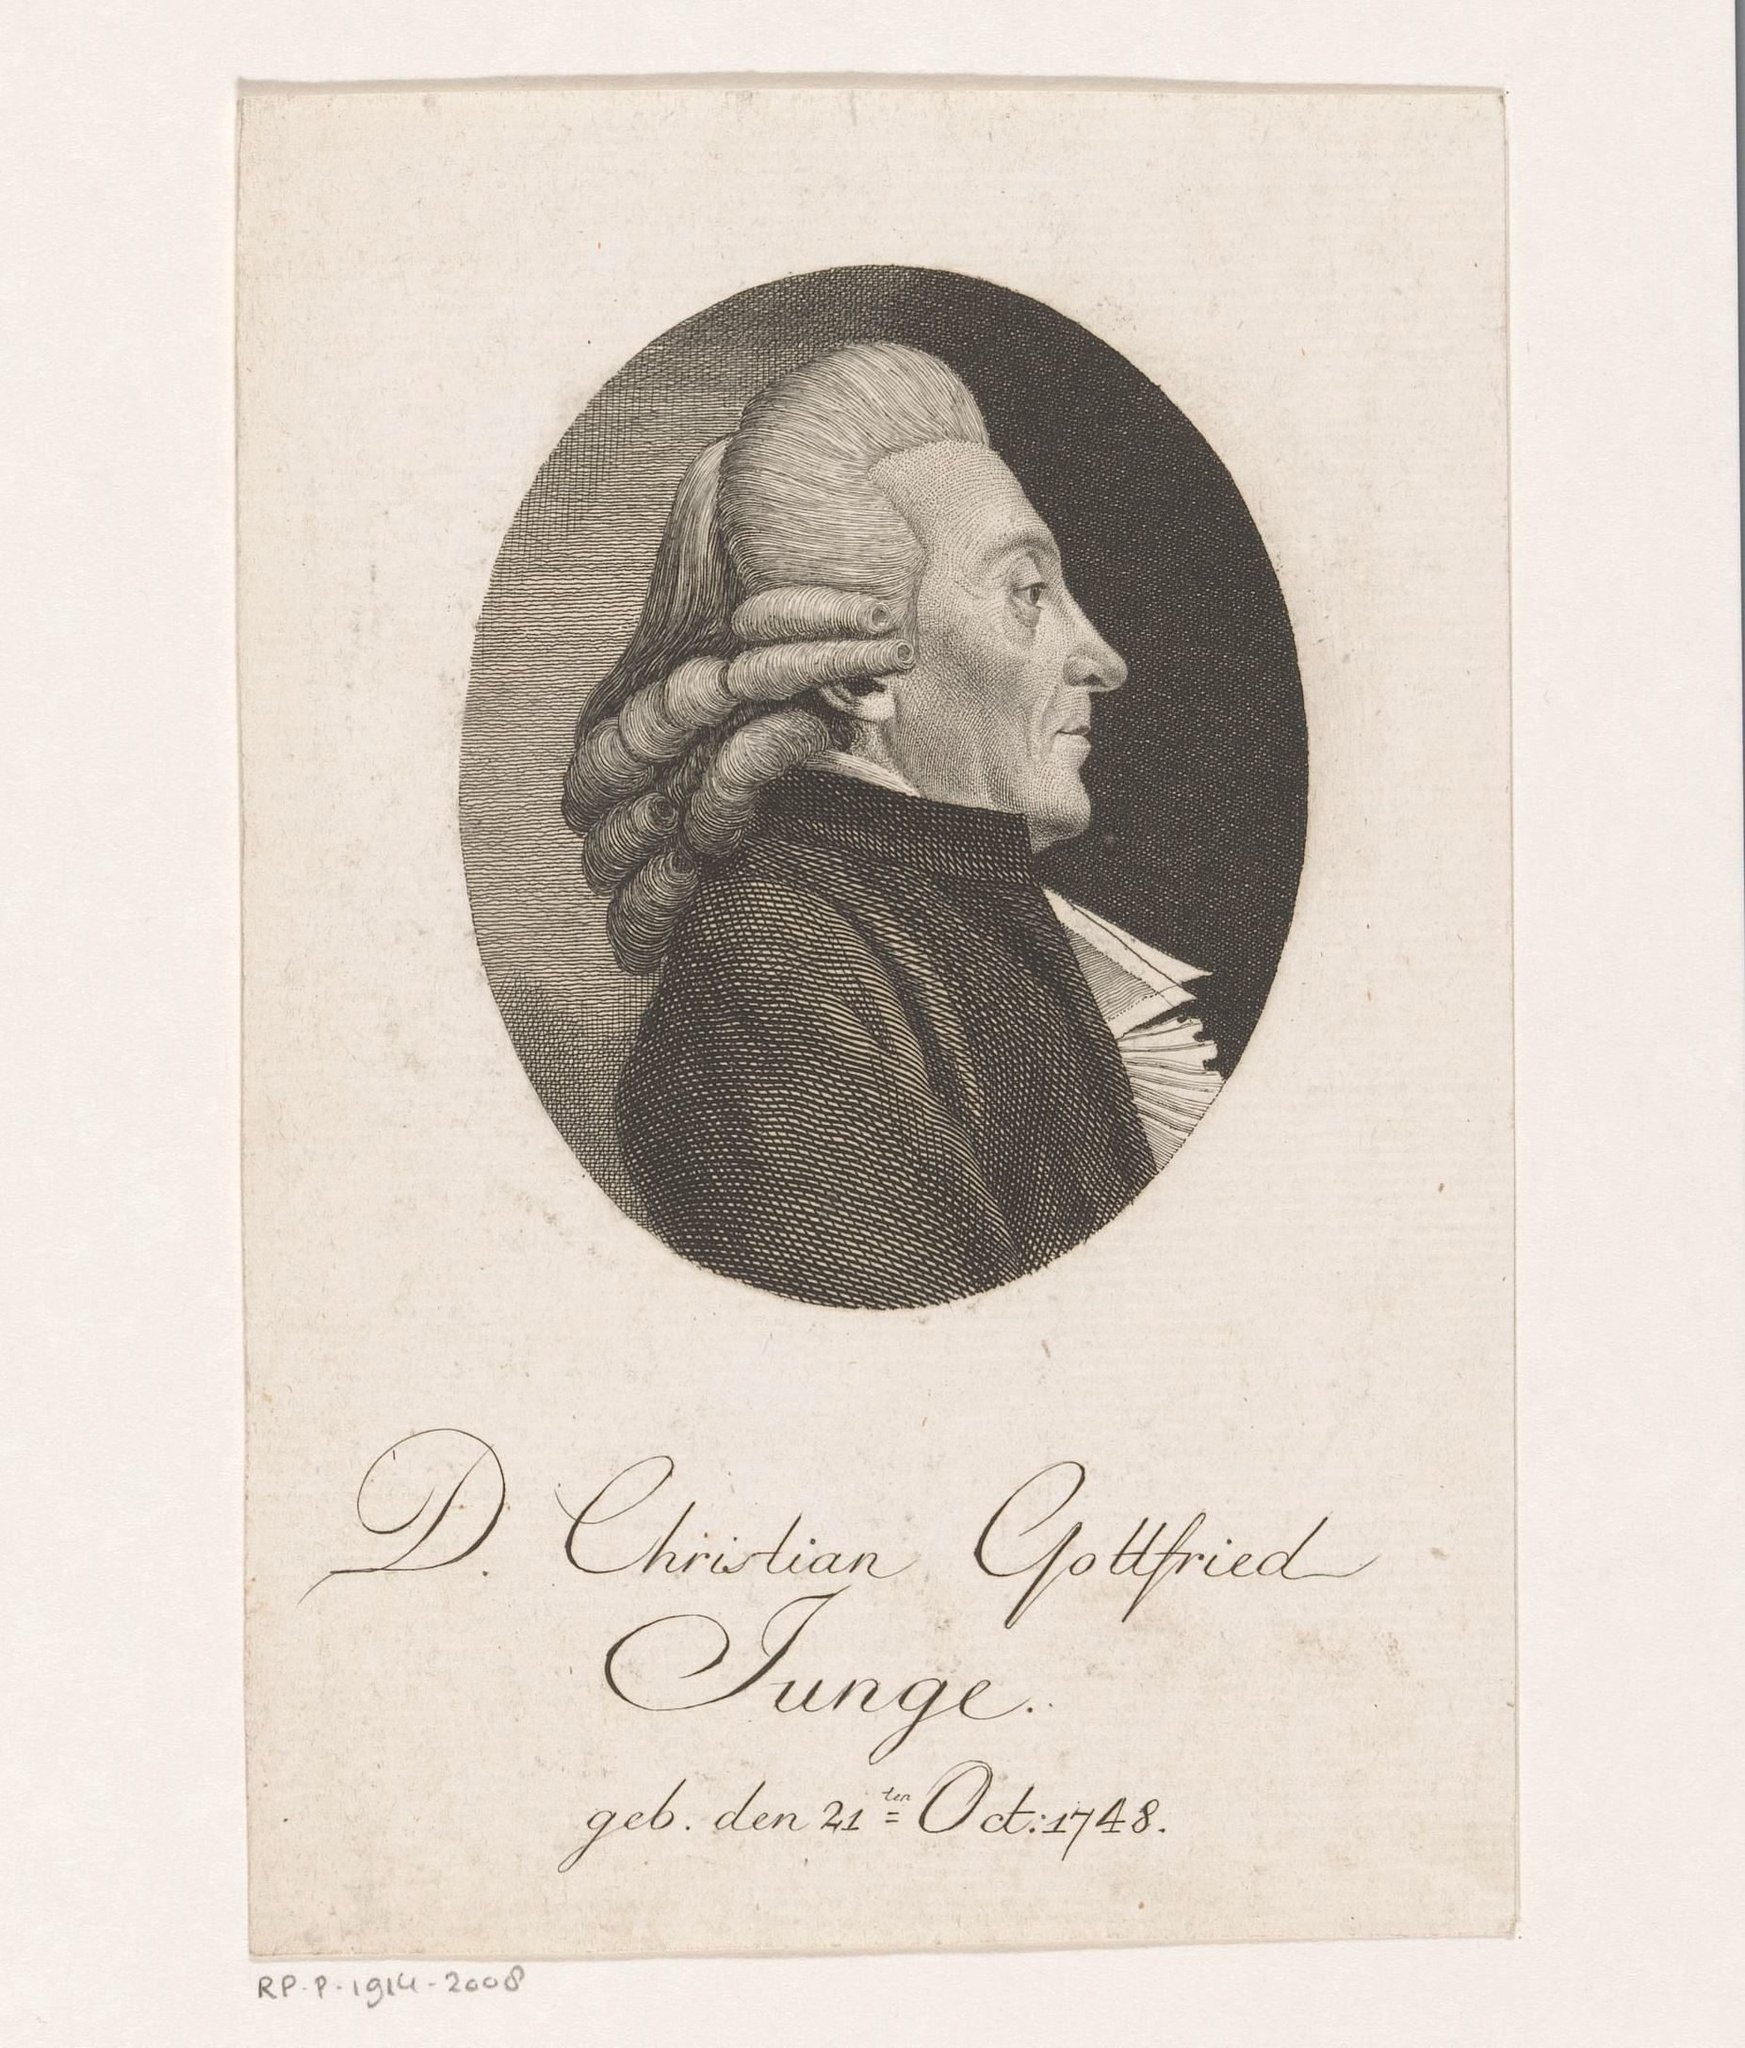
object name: print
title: Portret van Christian Gottfried Junge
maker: christoph wilhelm bock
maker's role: print maker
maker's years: 1755-1836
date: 1794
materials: paper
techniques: engraving, etching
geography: nuremberg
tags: historical persons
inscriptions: collector's mark: Lugt 2228